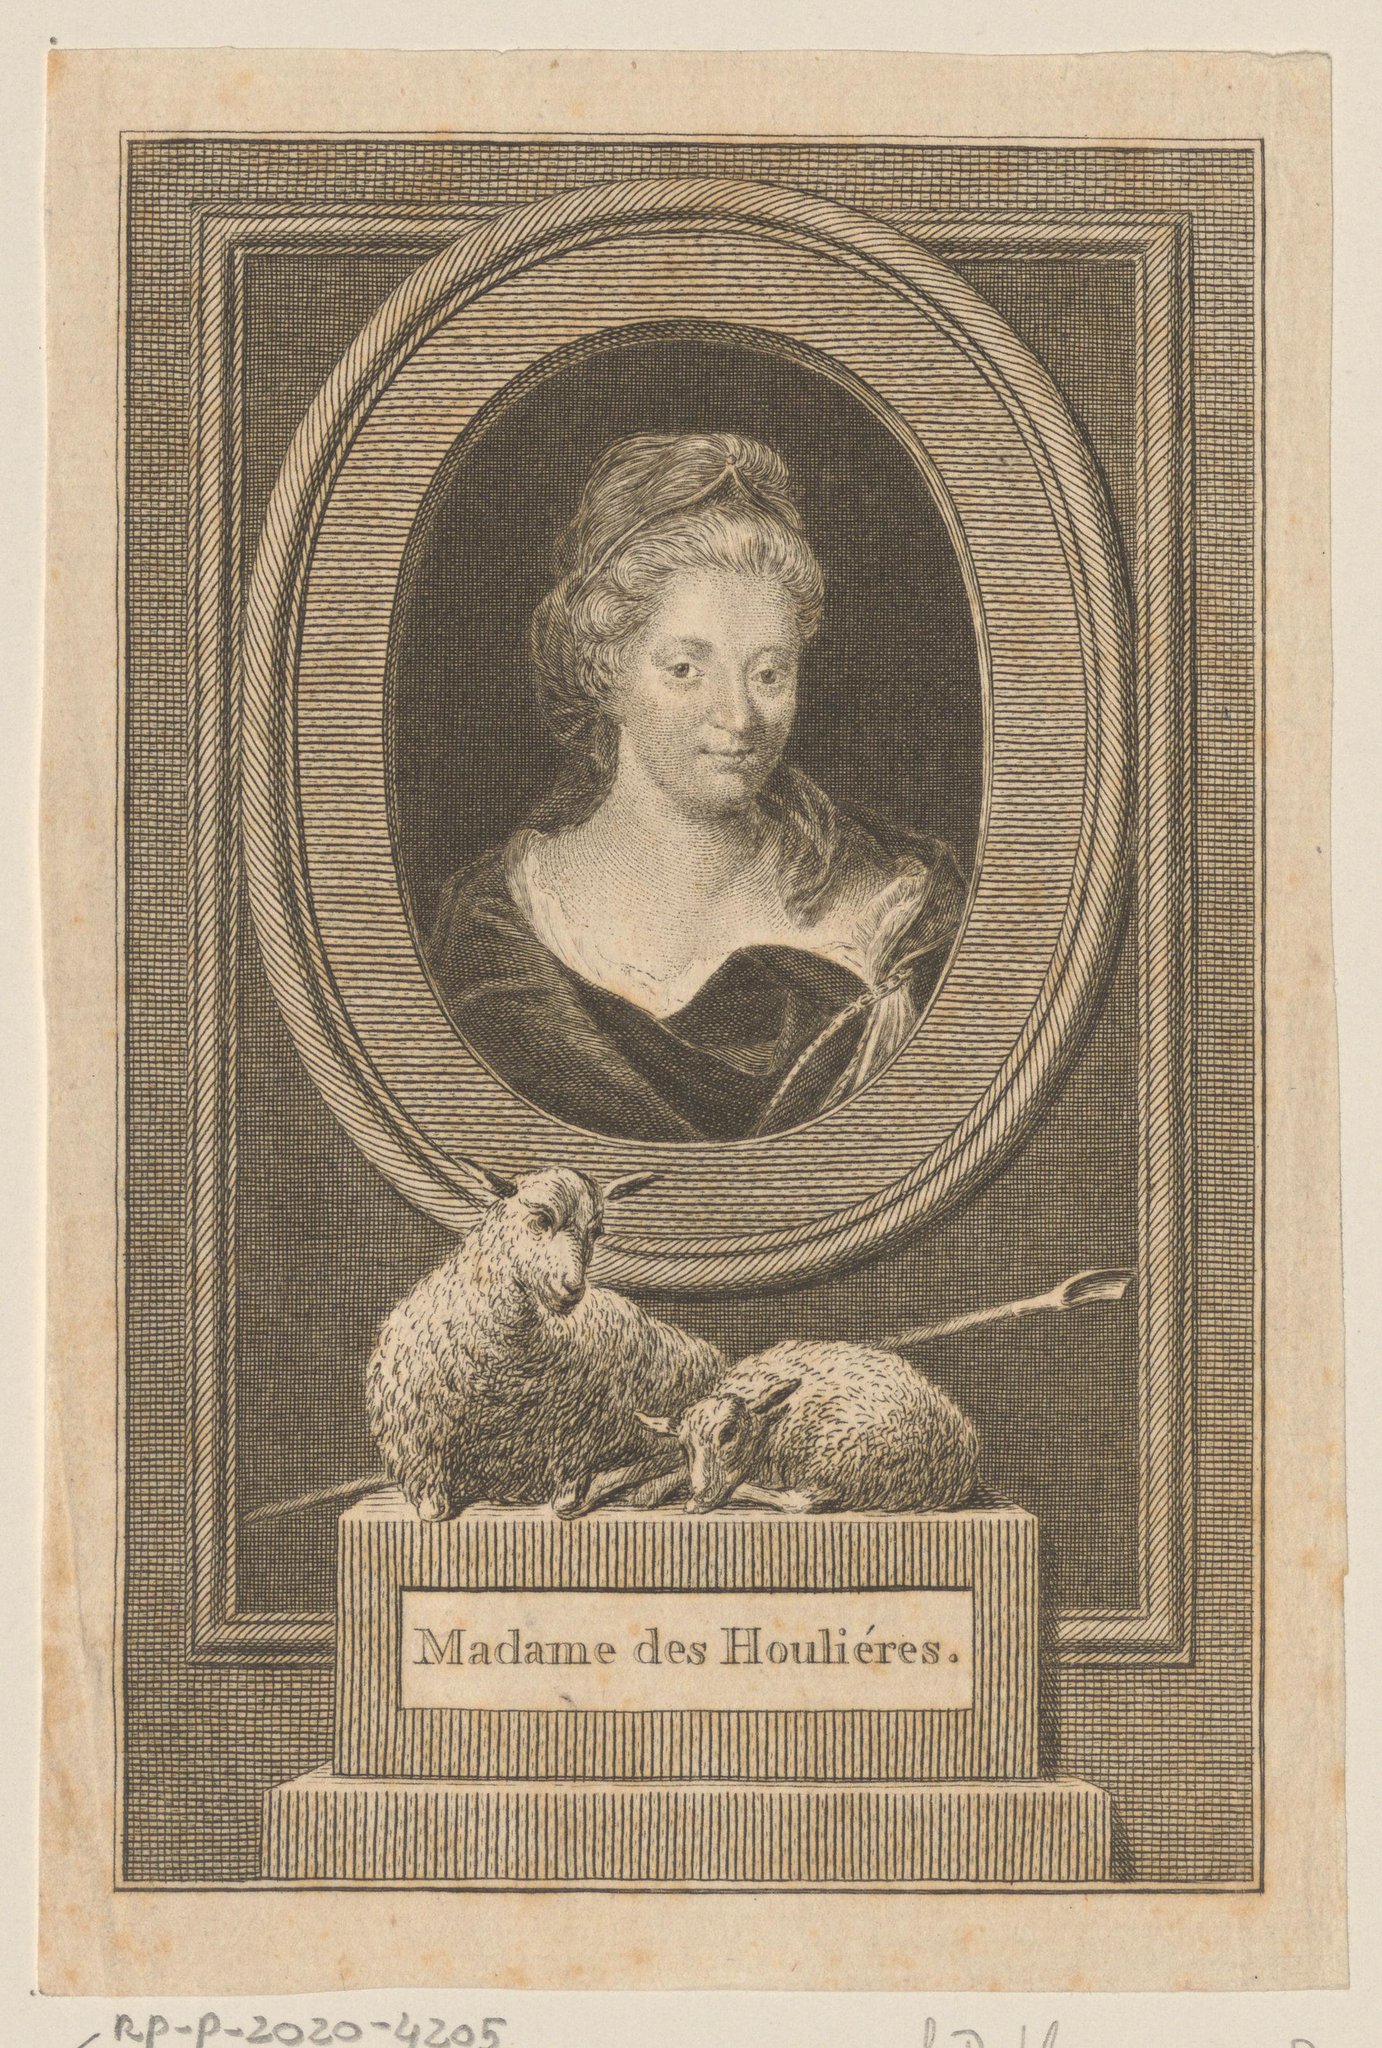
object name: print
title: Portret van Antoinette du Ligier de la Garde Deshoulières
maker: Anonymous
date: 1700-1799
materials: paper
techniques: engraving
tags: paris, historical persons, portrait of a writer, sheep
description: Met onder het portret twee liggende schapen en een staf.